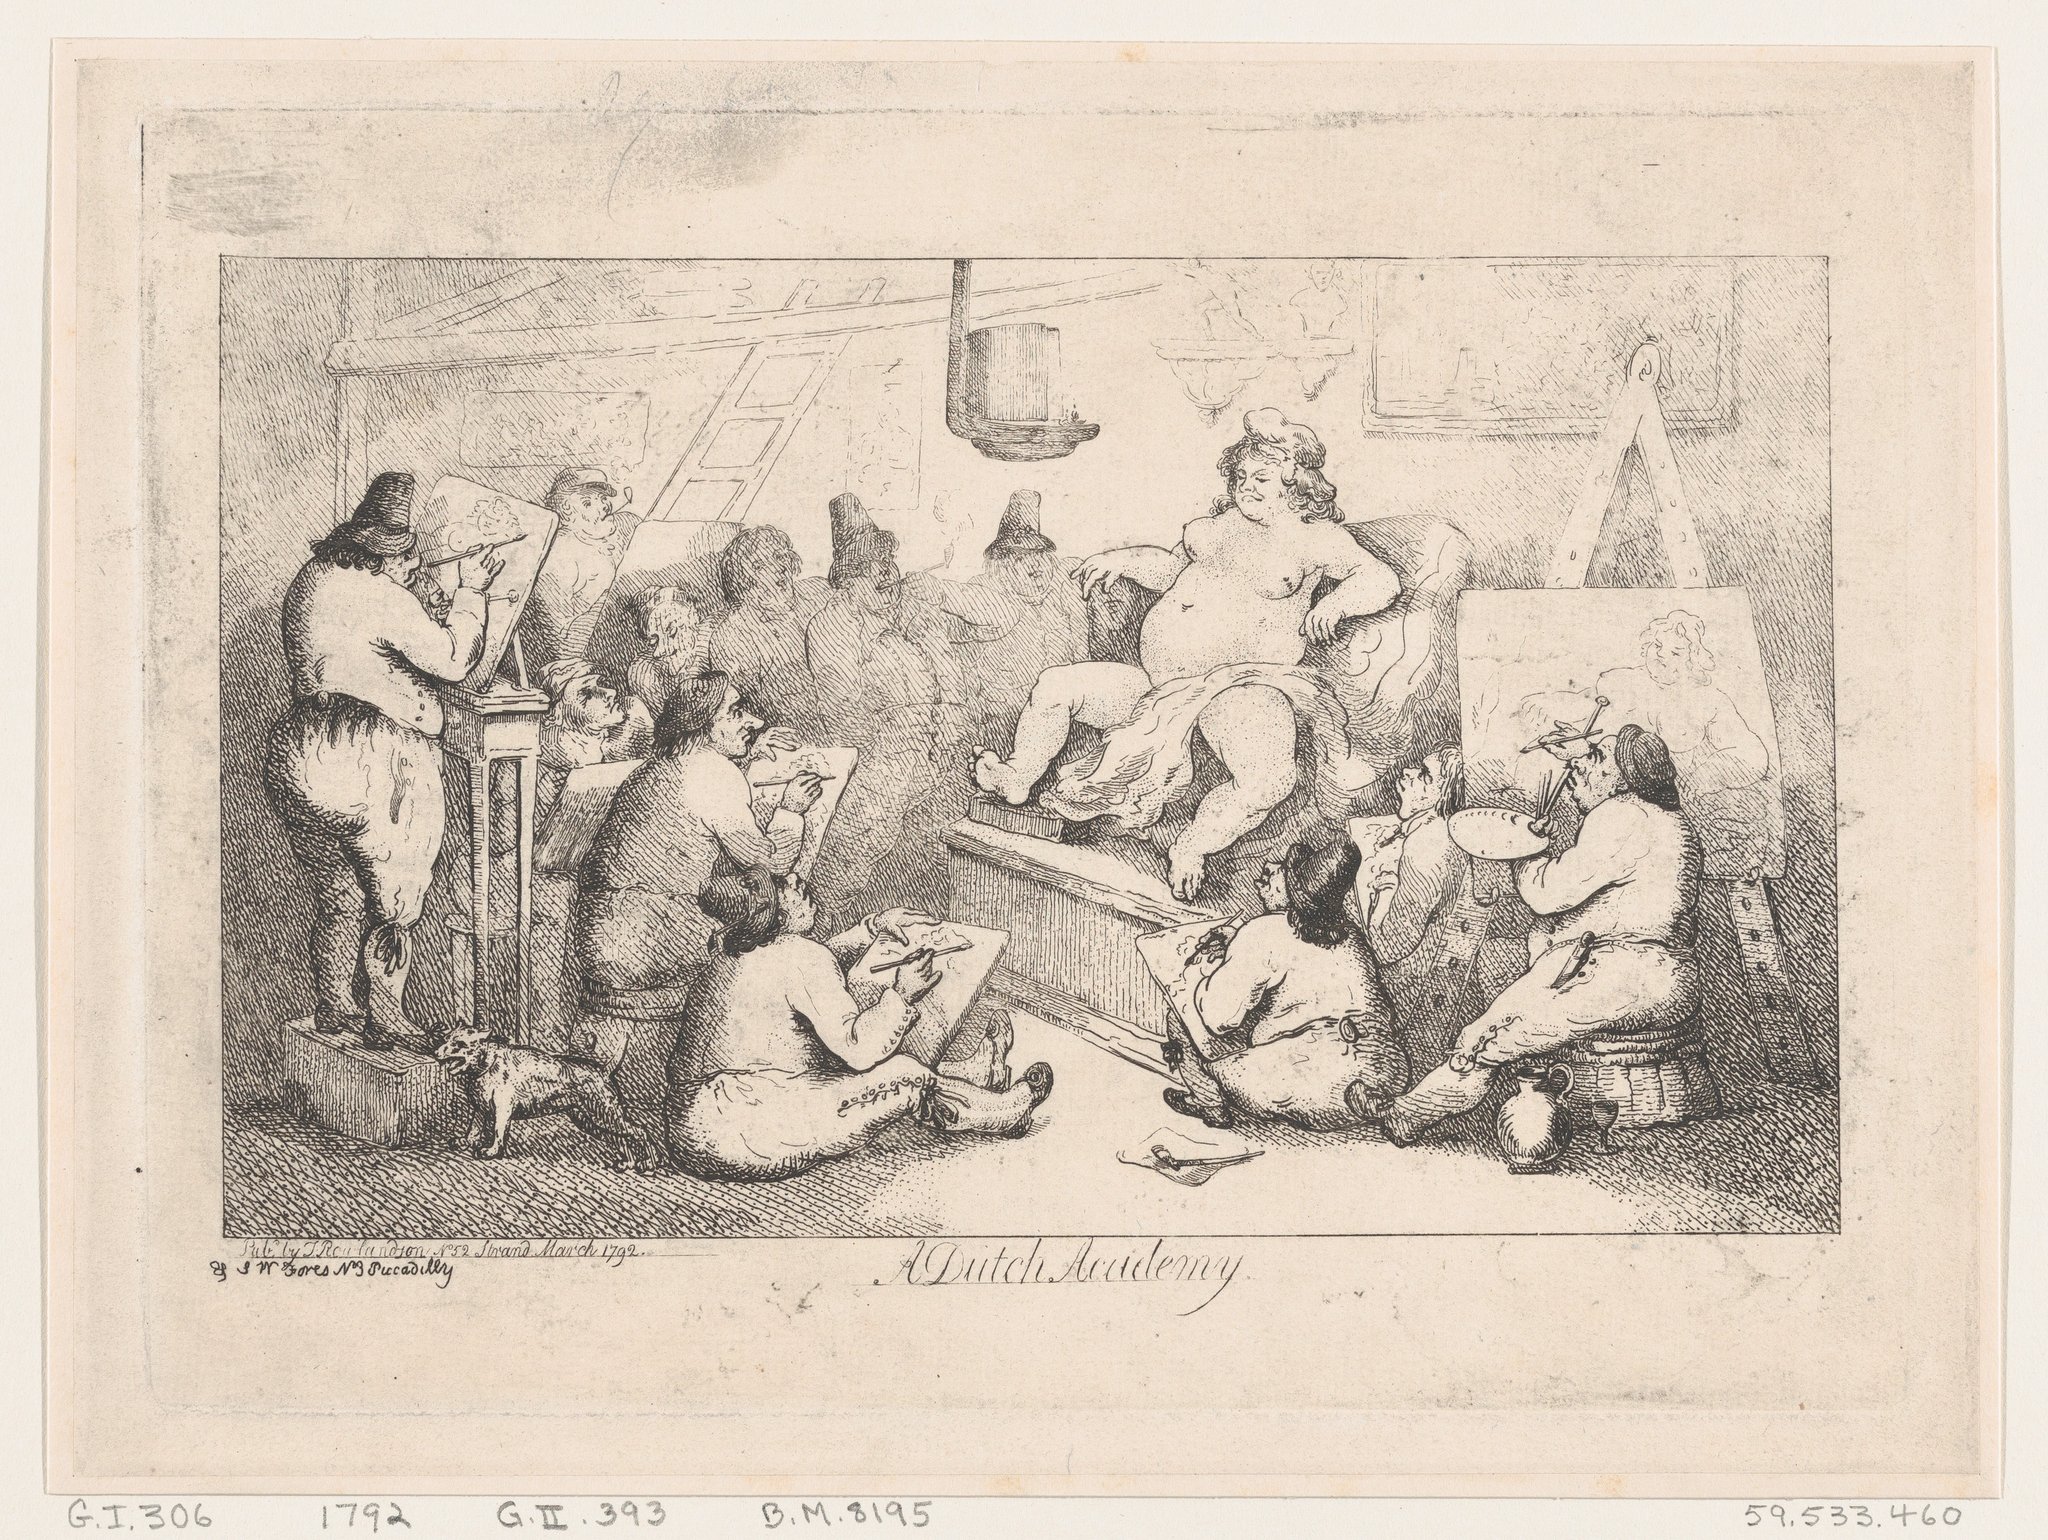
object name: print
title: Dutch Academy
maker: thomas rowlandson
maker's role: artist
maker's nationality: british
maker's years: 1757-1827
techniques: etching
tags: painting,men,female nudes